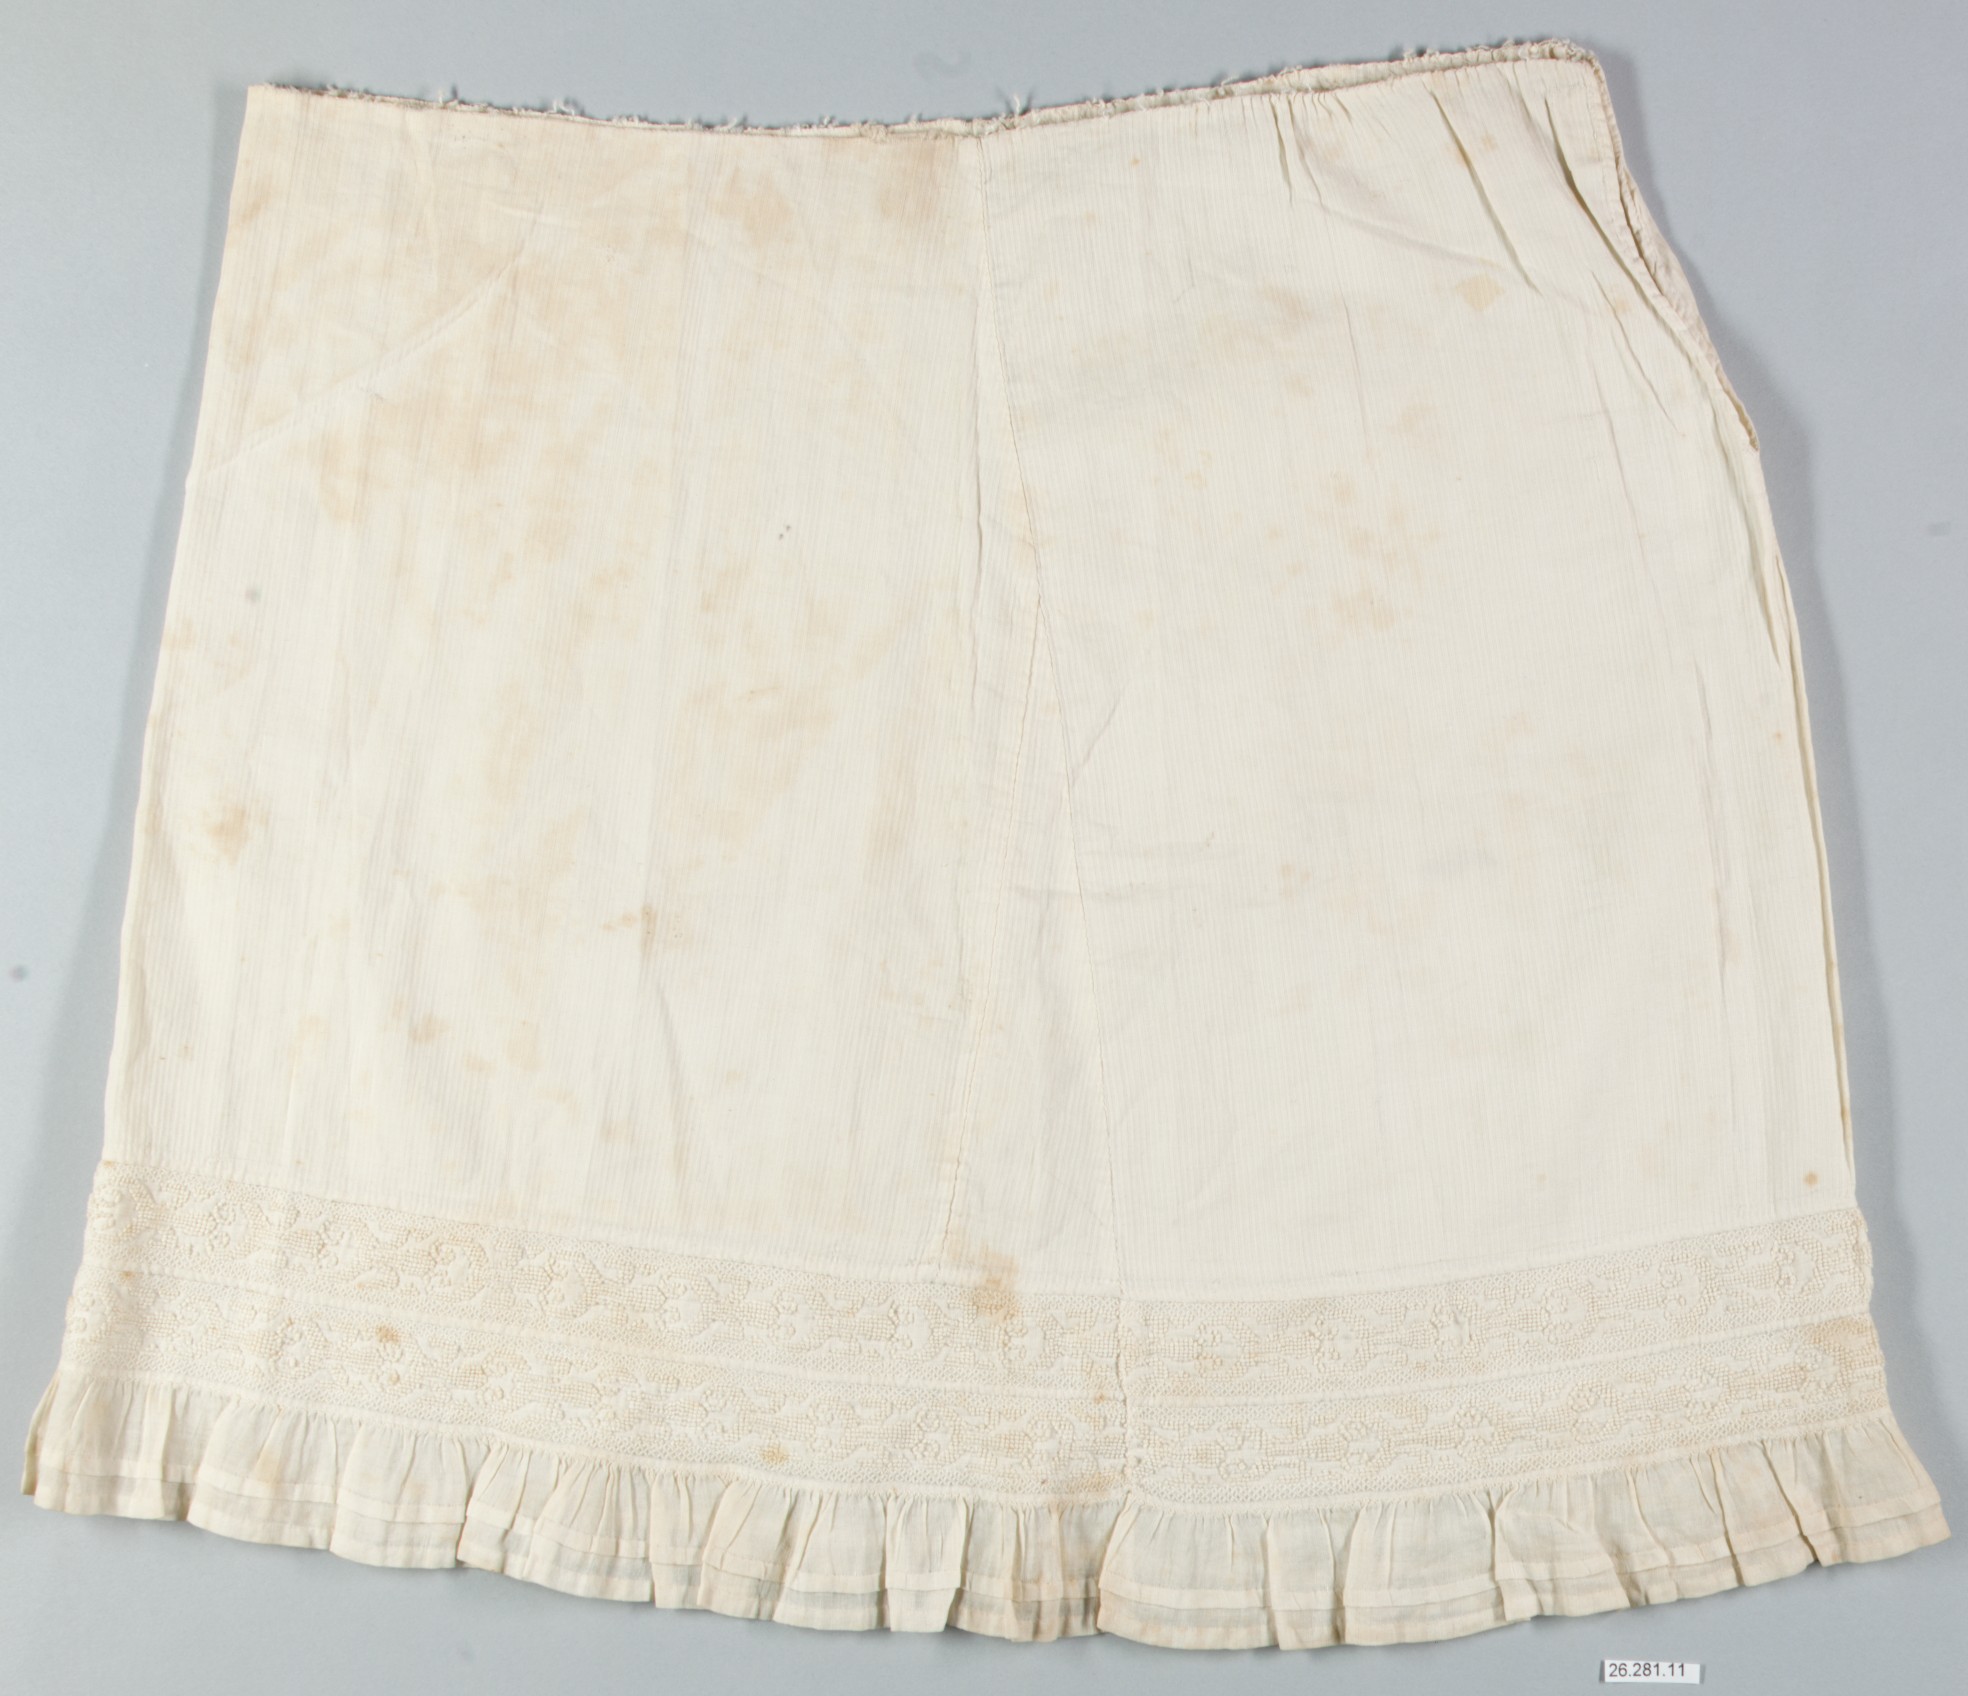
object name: petticoat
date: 1801-1900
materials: cotton